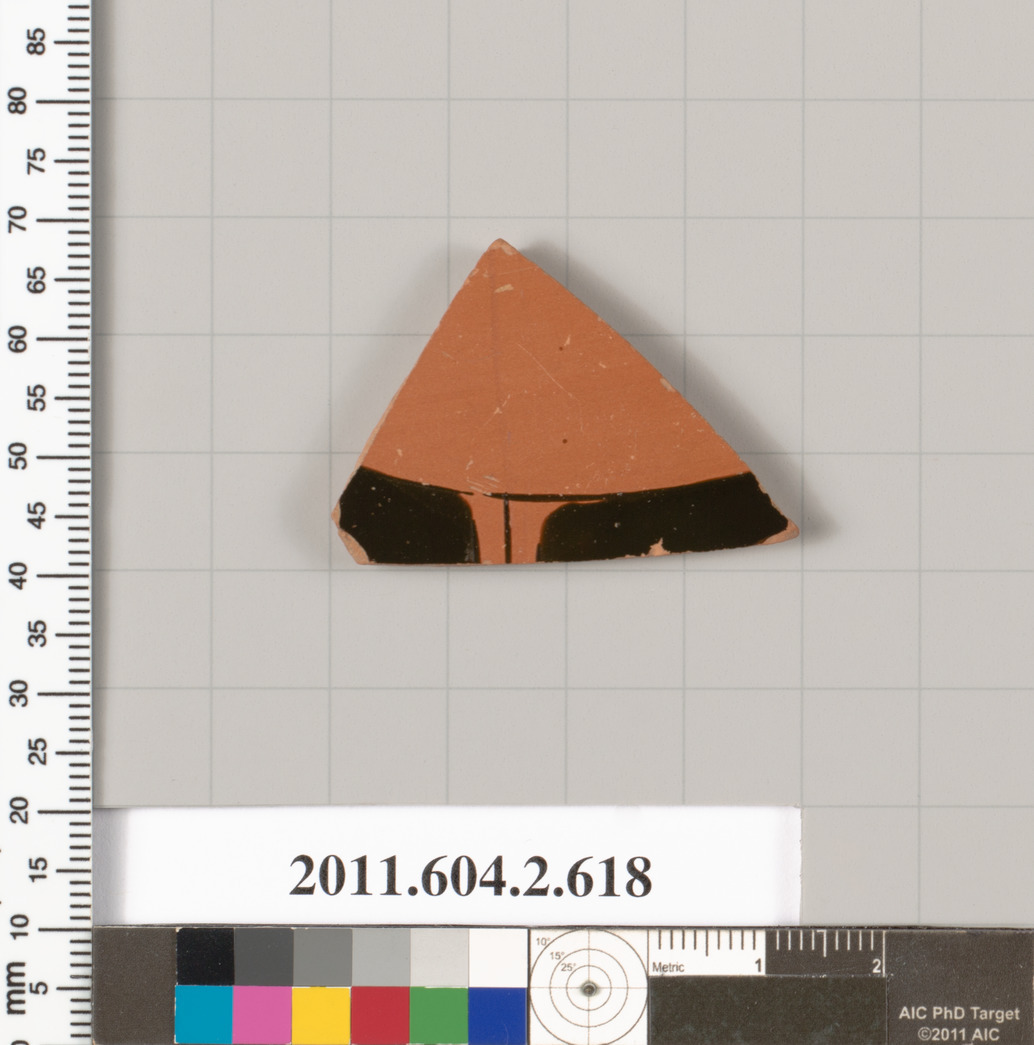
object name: column krater fragment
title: Terracotta fragment of a column-krater (bowl for mixing wine and water)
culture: greek, attic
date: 460-440 BCE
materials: terracotta